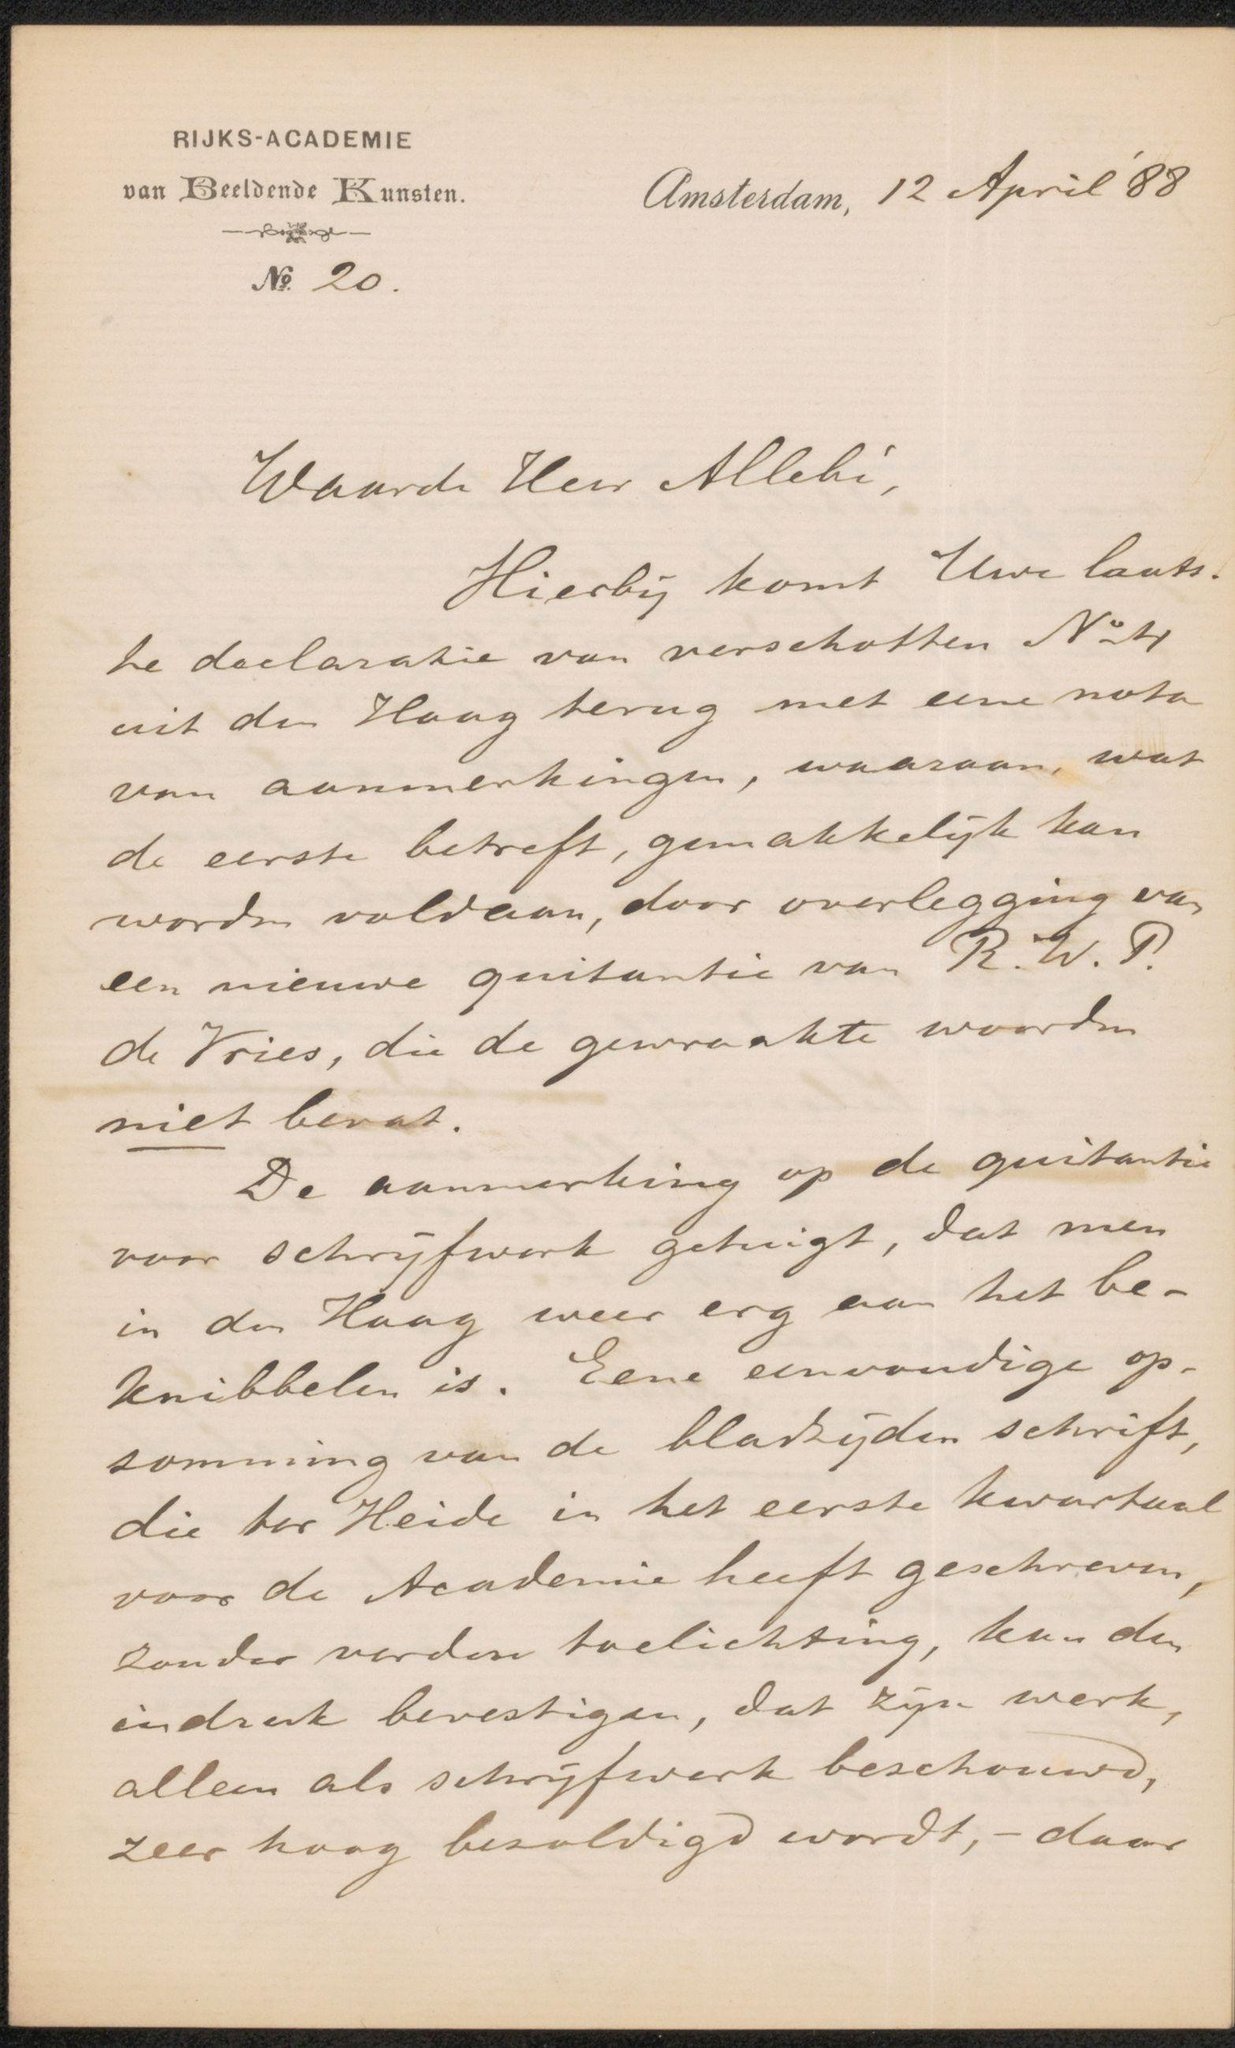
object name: letter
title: Brief aan August Allebé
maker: jérôme alexander sillem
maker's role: politician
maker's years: 1840-1912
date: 1888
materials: ink, paper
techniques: pen, printing, writing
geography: amsterdam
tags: official, j.g. ter heide, draughtsman, august allebé, amsterdam, auctioneer, publisher, reinier willem petrus de vries (1841-1919), hendrick peter godfried quack, travelling; tourism, money